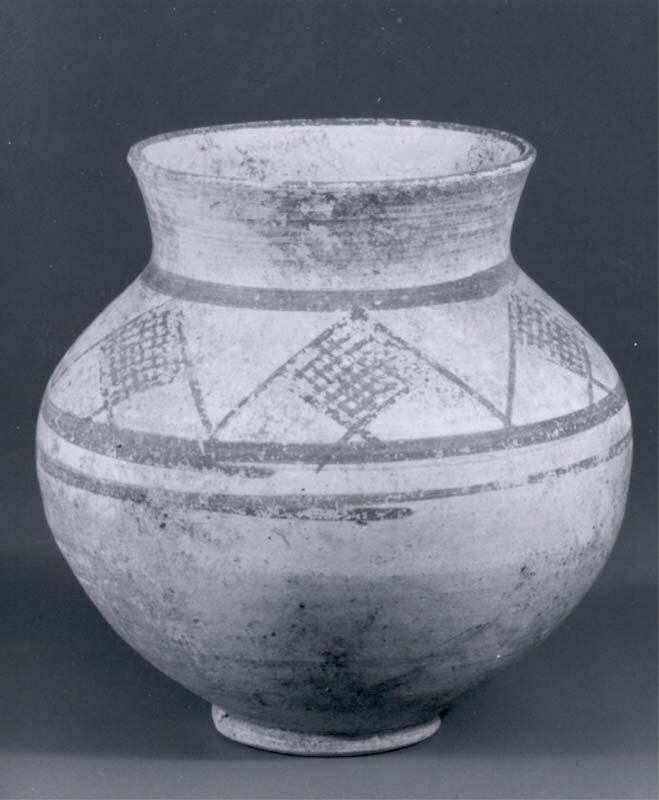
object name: jar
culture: iranian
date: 1900-1501 BCE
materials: ceramic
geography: iran